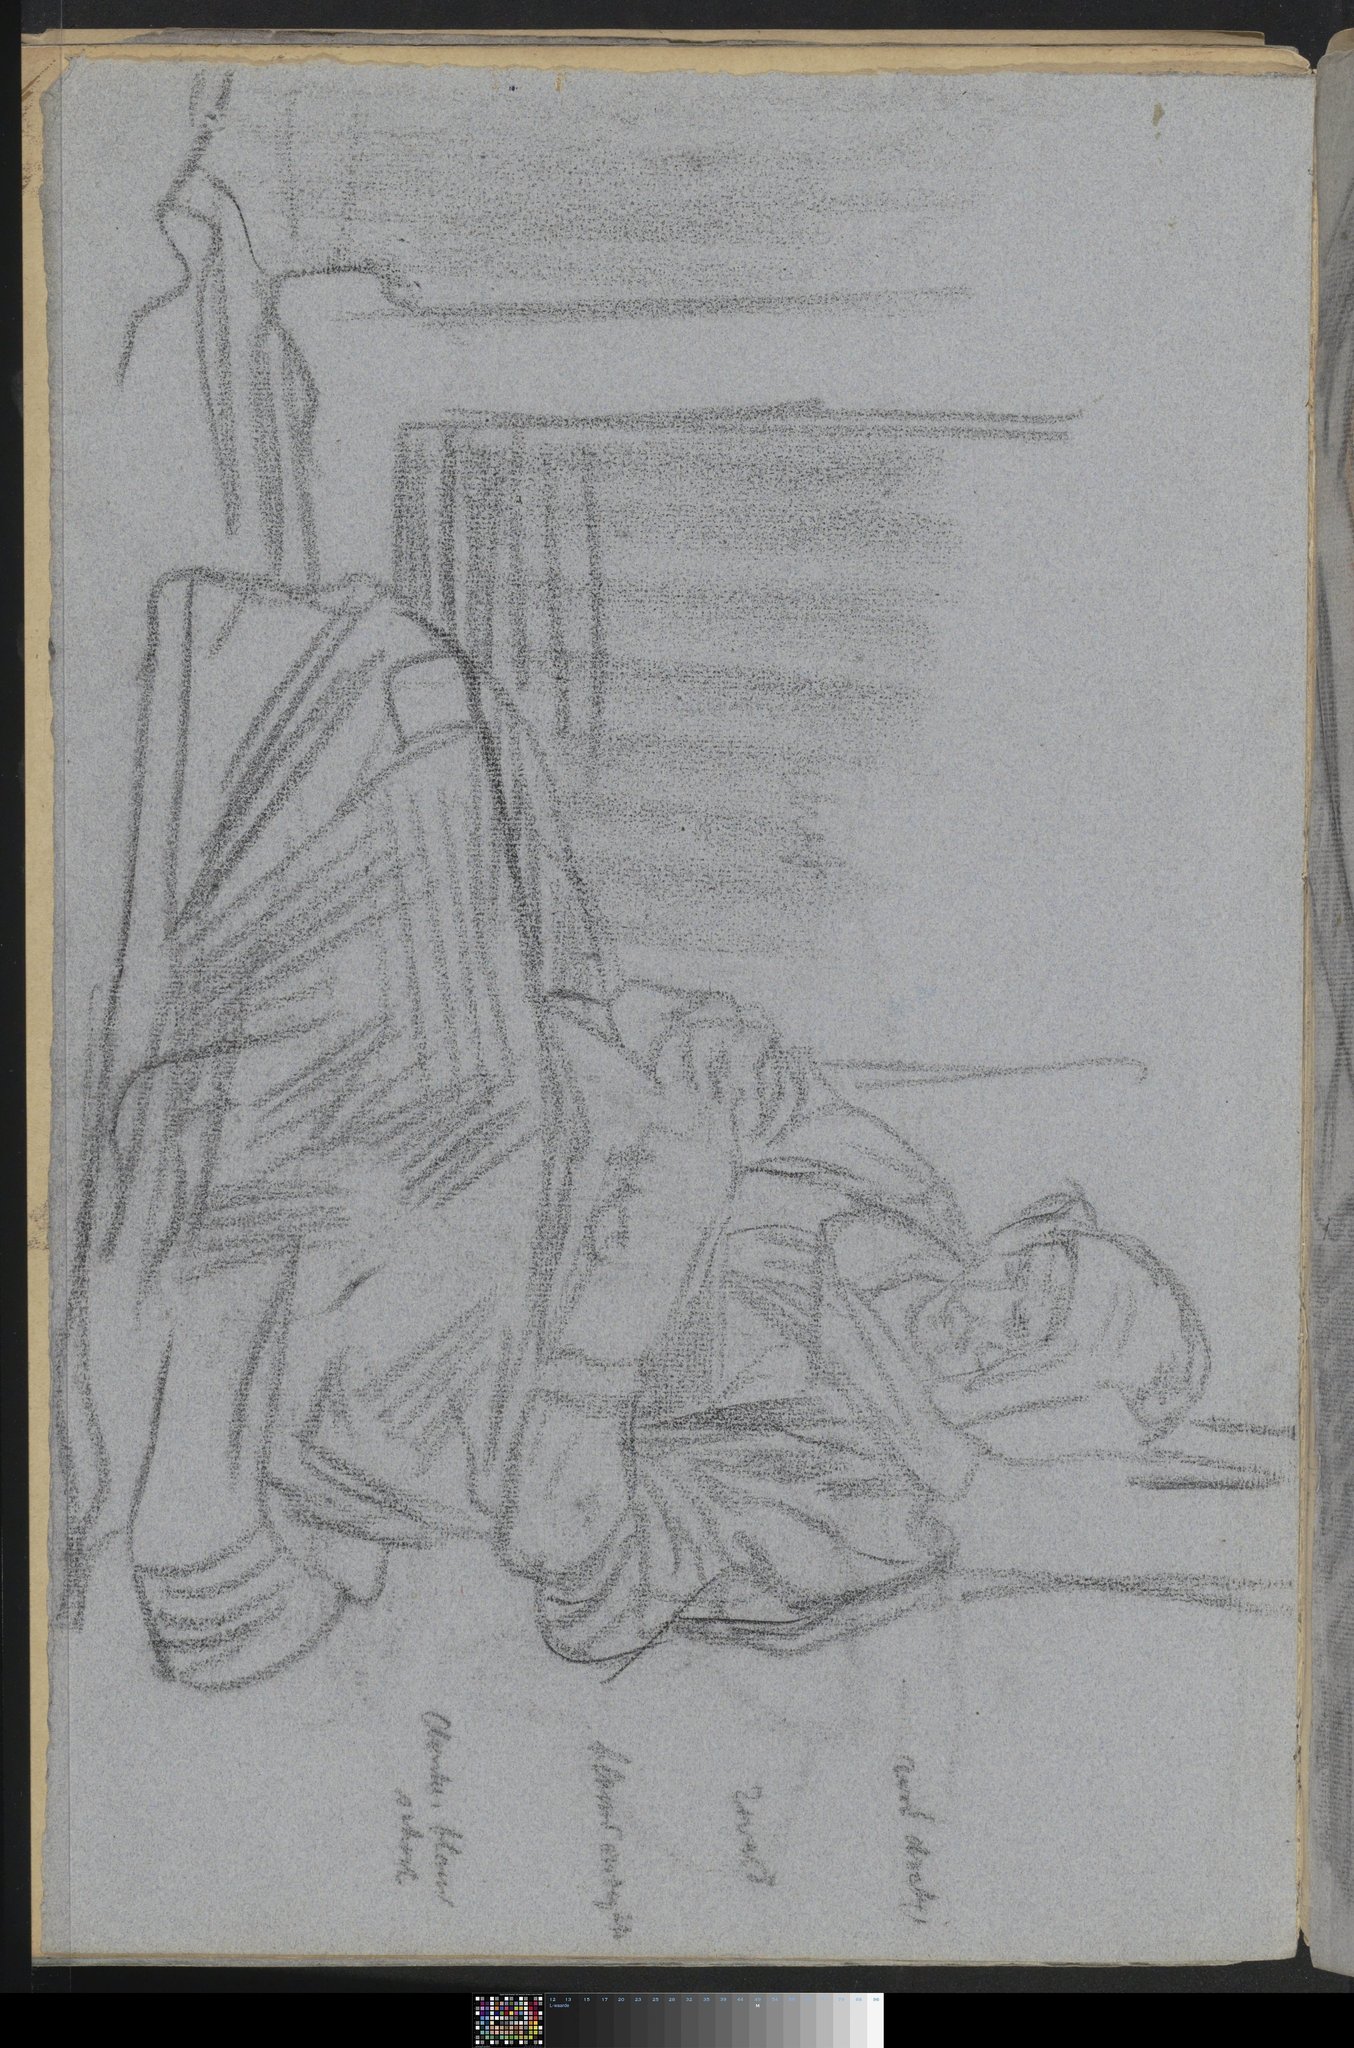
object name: sketchbook leaf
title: Handwerkende vrouw bij een raam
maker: jan veth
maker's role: designer, draughtsman, painter, print maker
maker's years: 1864-1925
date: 1874-1925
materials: chalk, paper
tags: sitting figure, adult woman, window, head-gear: cap (+ women's clothes), home sewing; repair of clothes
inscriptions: kleurnotitie, handgeschreven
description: De vrouw draagt een kapje op het hoofd en zit op een kruk. Blad 42 verso uit een schetsboek met 42 bladen.